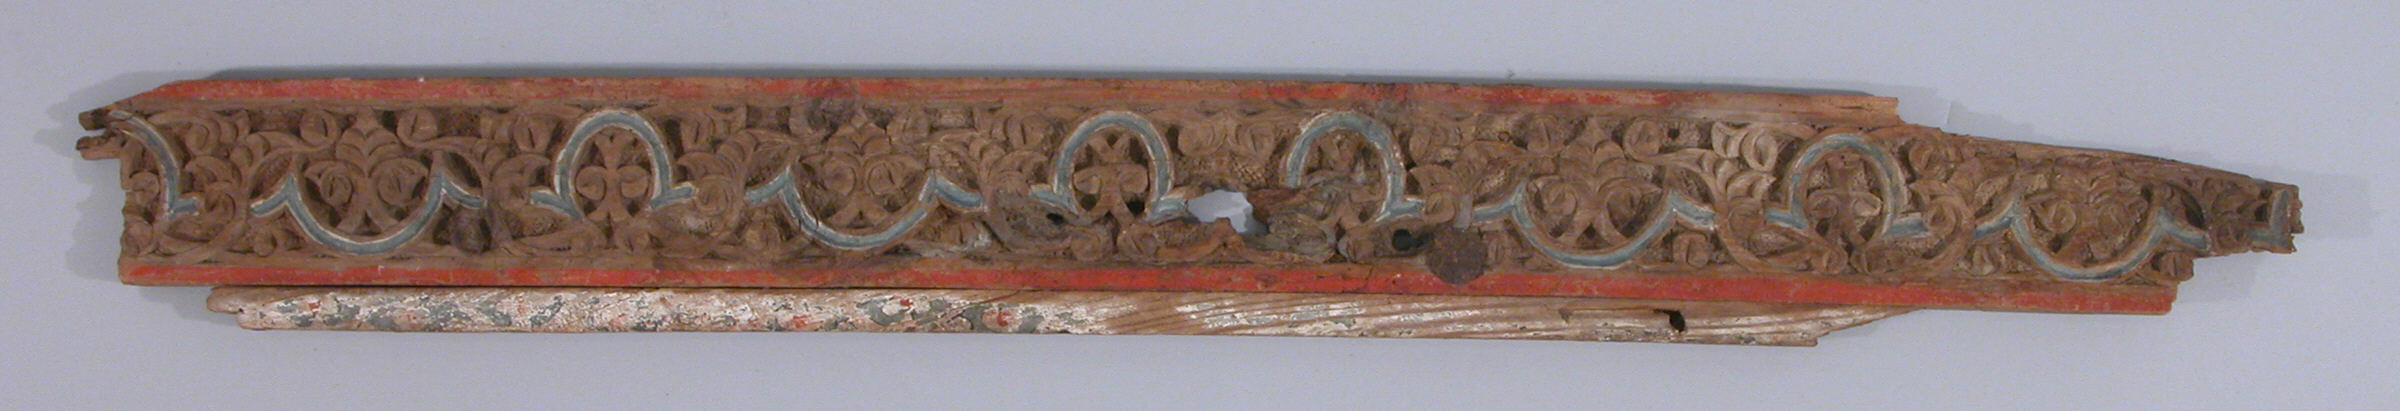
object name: panel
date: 1201-1300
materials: wood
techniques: carving, painting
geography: egypt